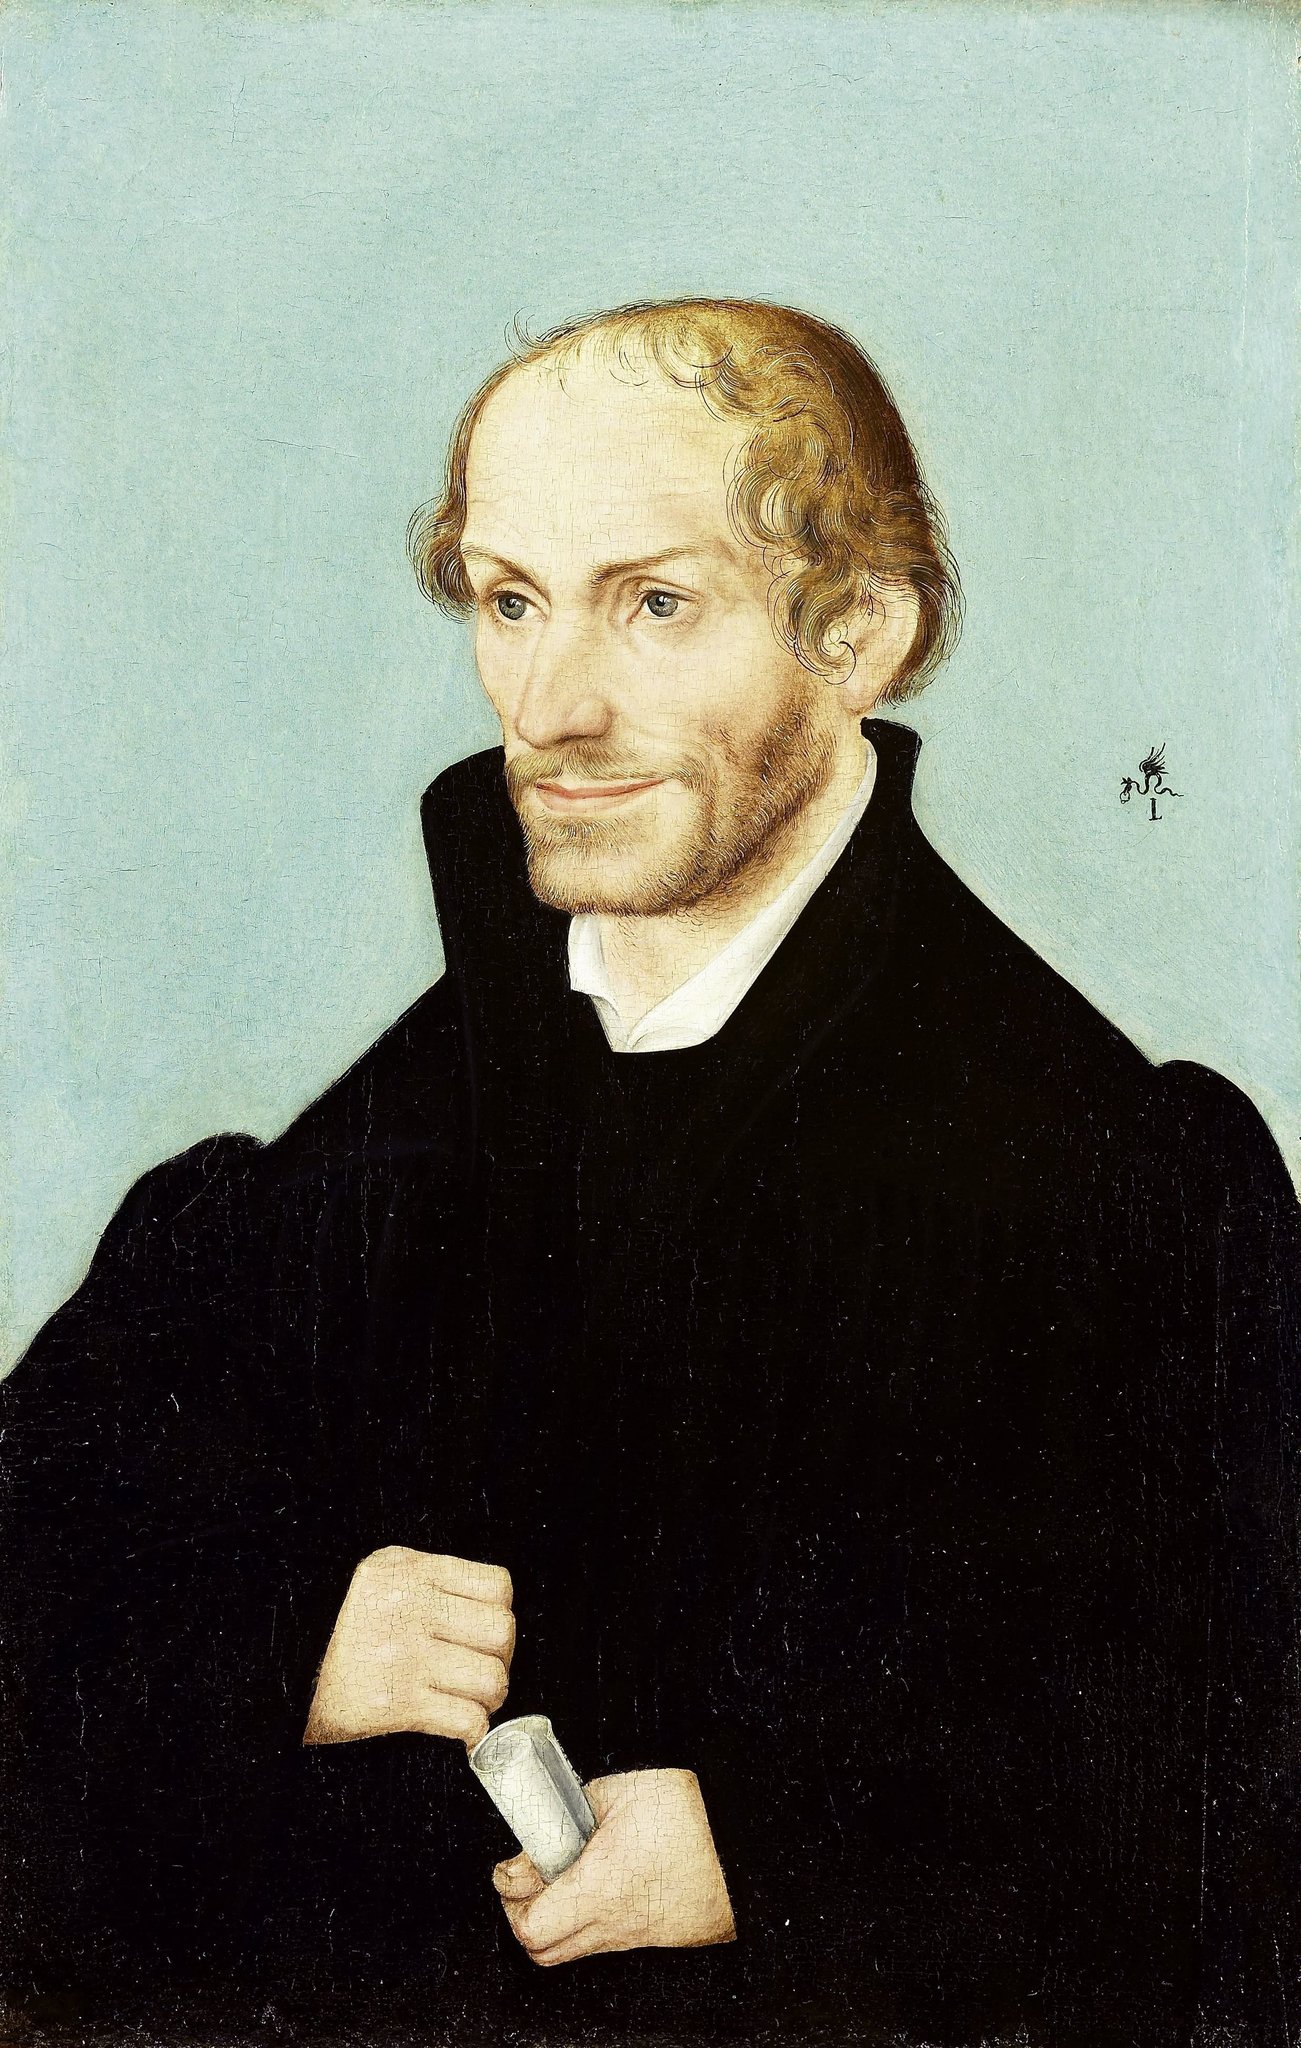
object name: painting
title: Philipp Melanchthon, Leading Figure of the Reformation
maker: lucas cranach (i)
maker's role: draughtsman, print maker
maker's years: 1472-1553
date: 1540-1560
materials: oil, panel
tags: reformation (roman catholic church vs. protestantism), historical persons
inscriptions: signature: ‘L’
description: Portret van de Duitse kerkhervormer Philipp Melanchton (1497-1560), in de linkerhand een opgerold papier.